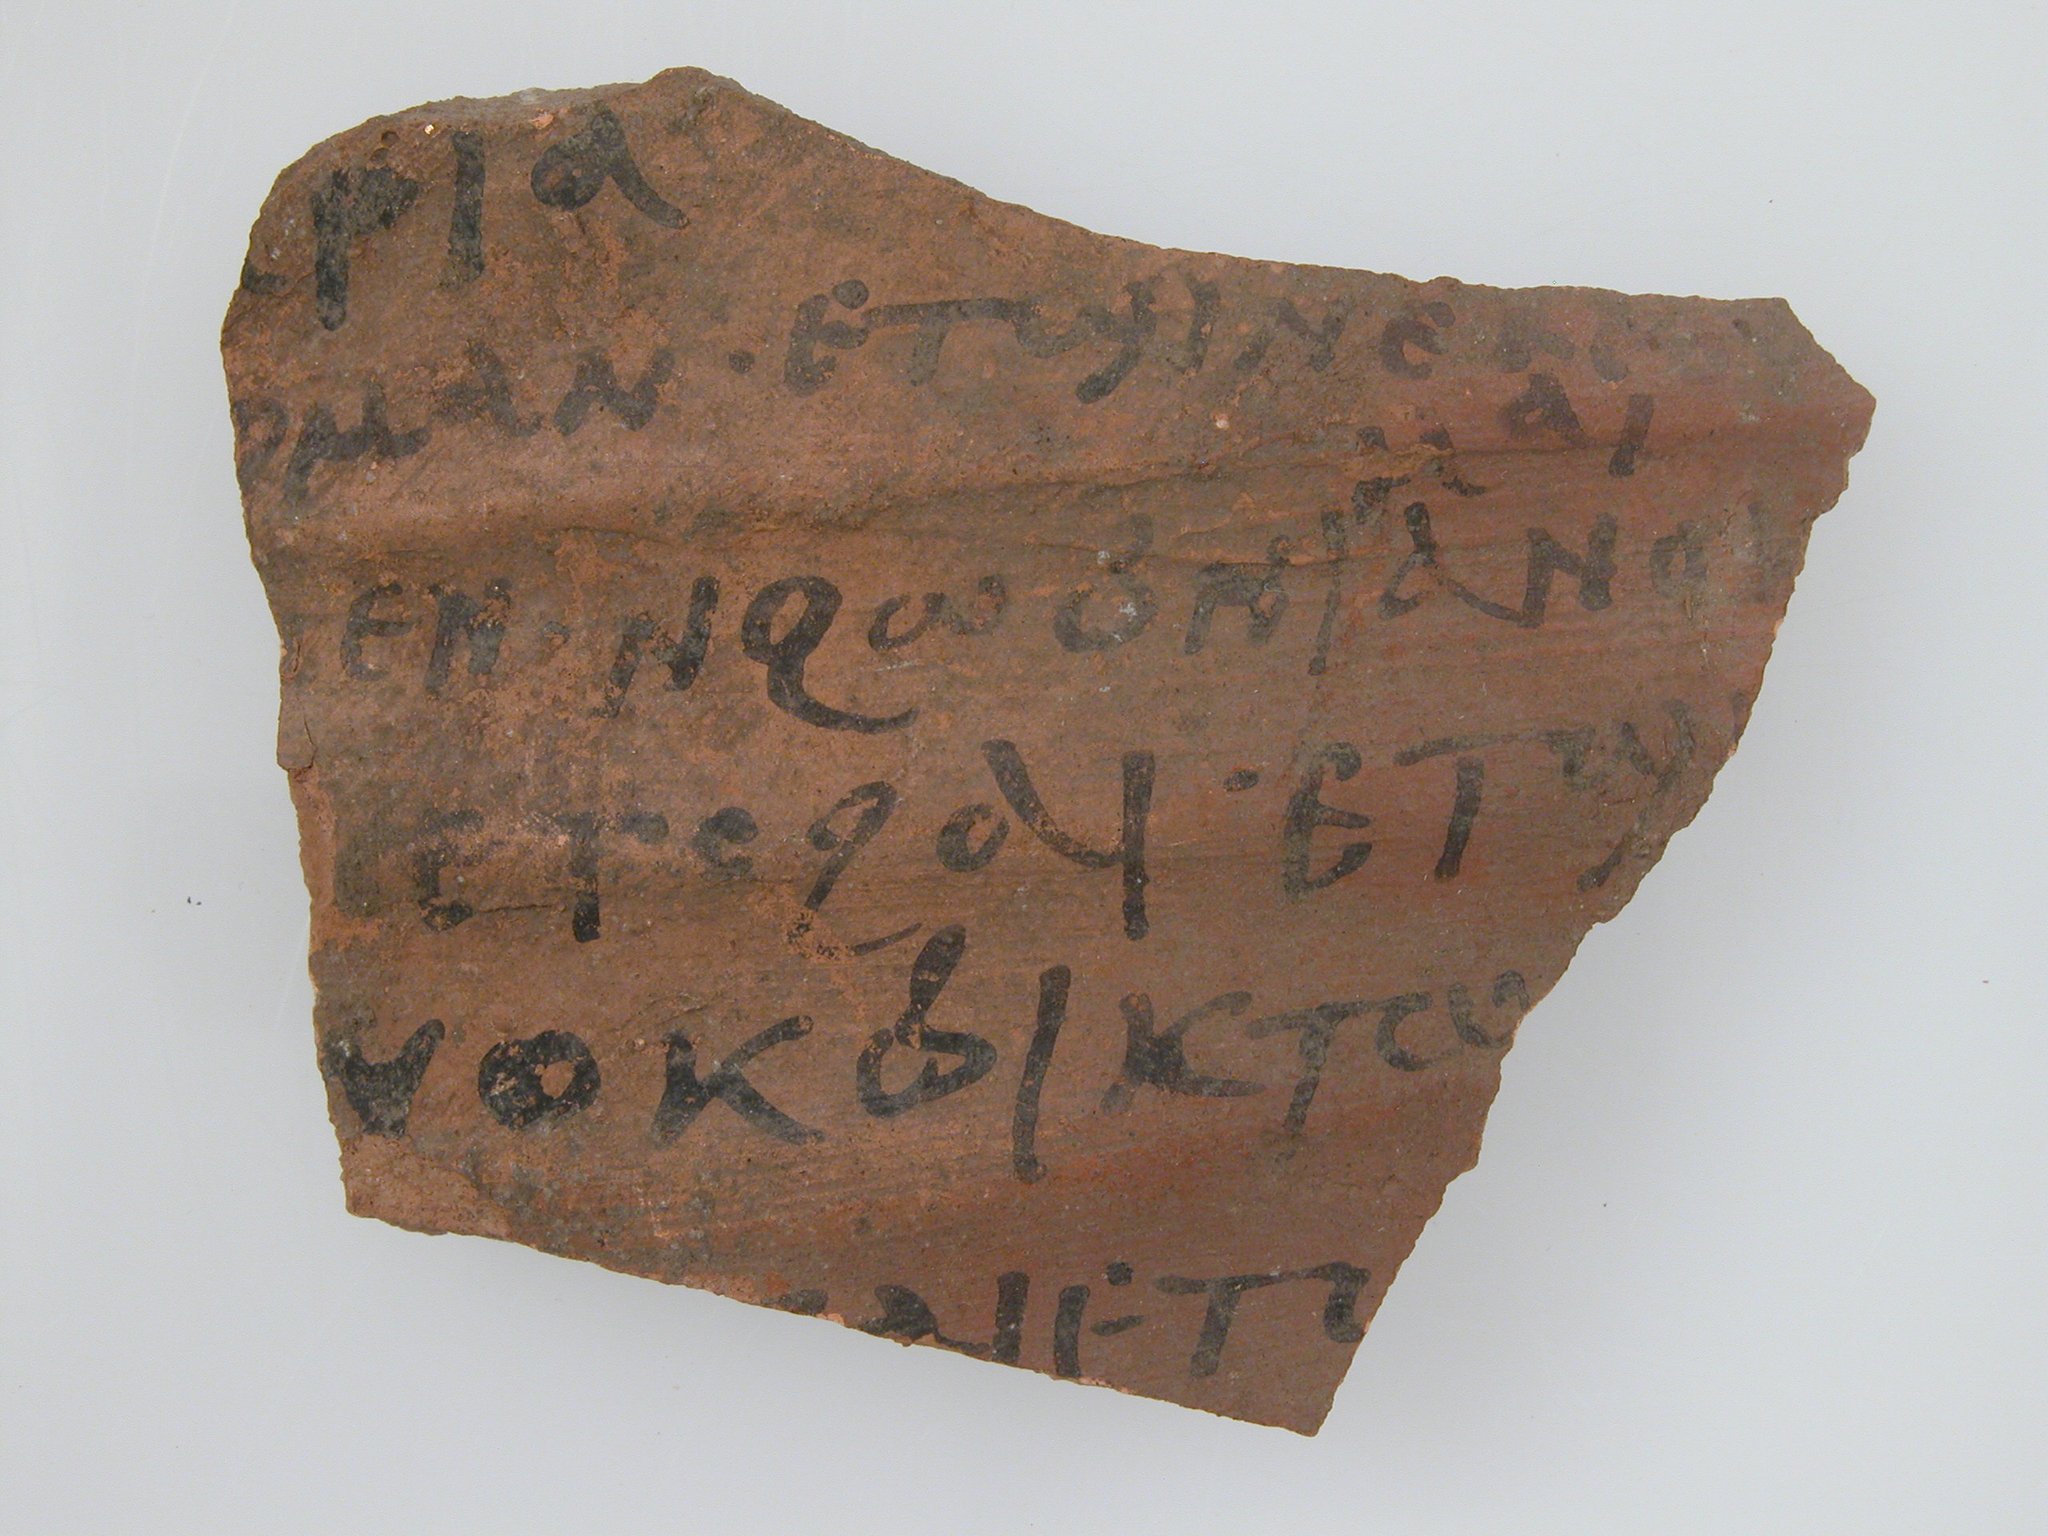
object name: ostrakon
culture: coptic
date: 600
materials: ink, pottery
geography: egypt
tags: coptic,documents